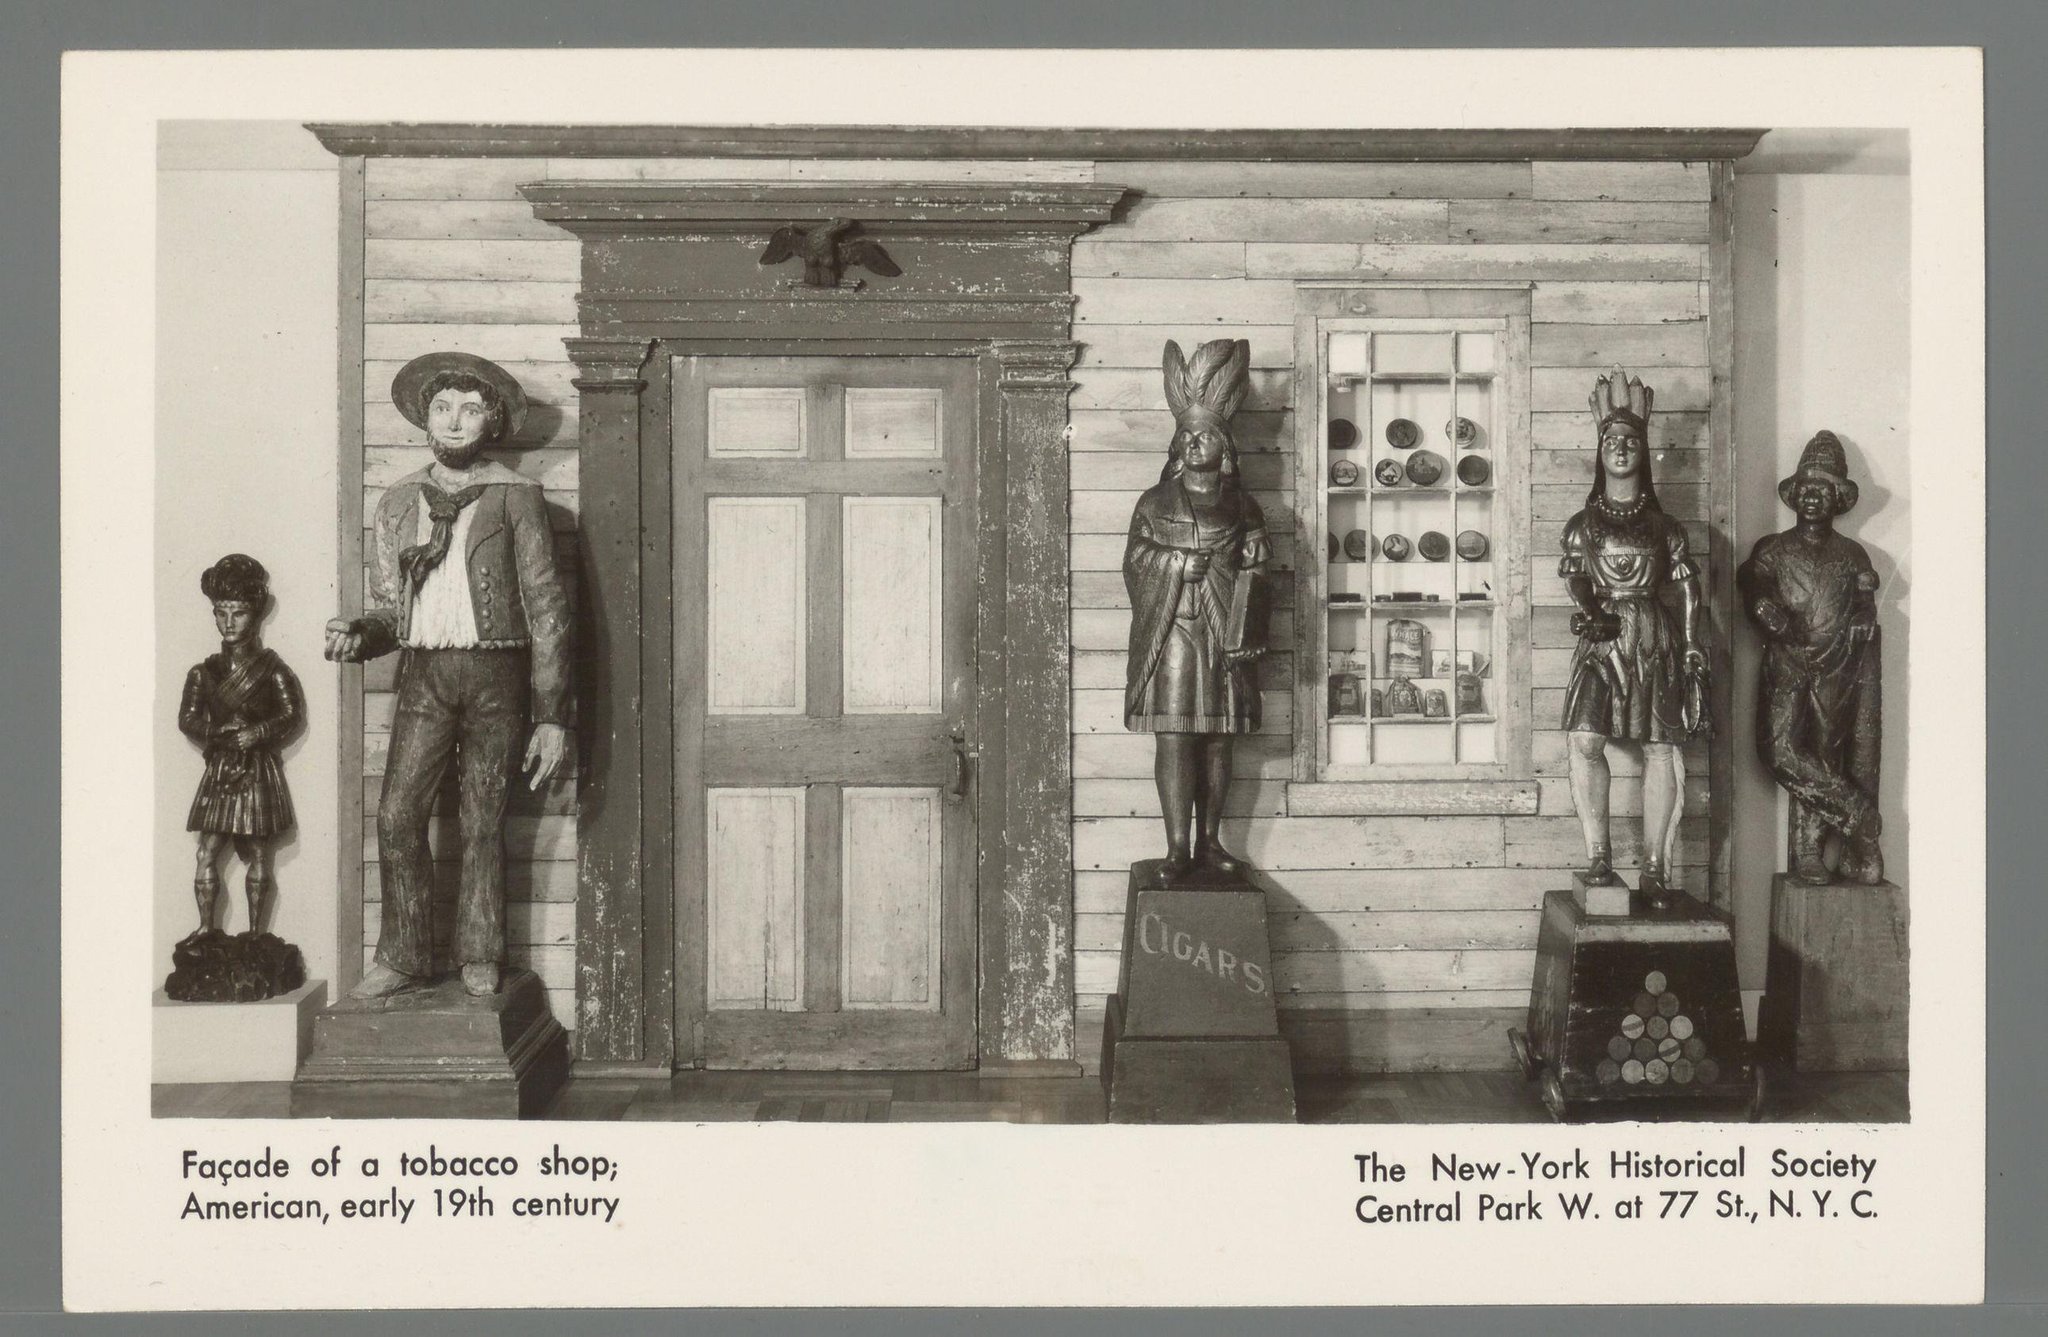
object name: photograph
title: Façade of a tobacco shop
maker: Anonymous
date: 1937-1950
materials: photographic support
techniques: photography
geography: new york city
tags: shop, store, sculpture, exhibition ~ art